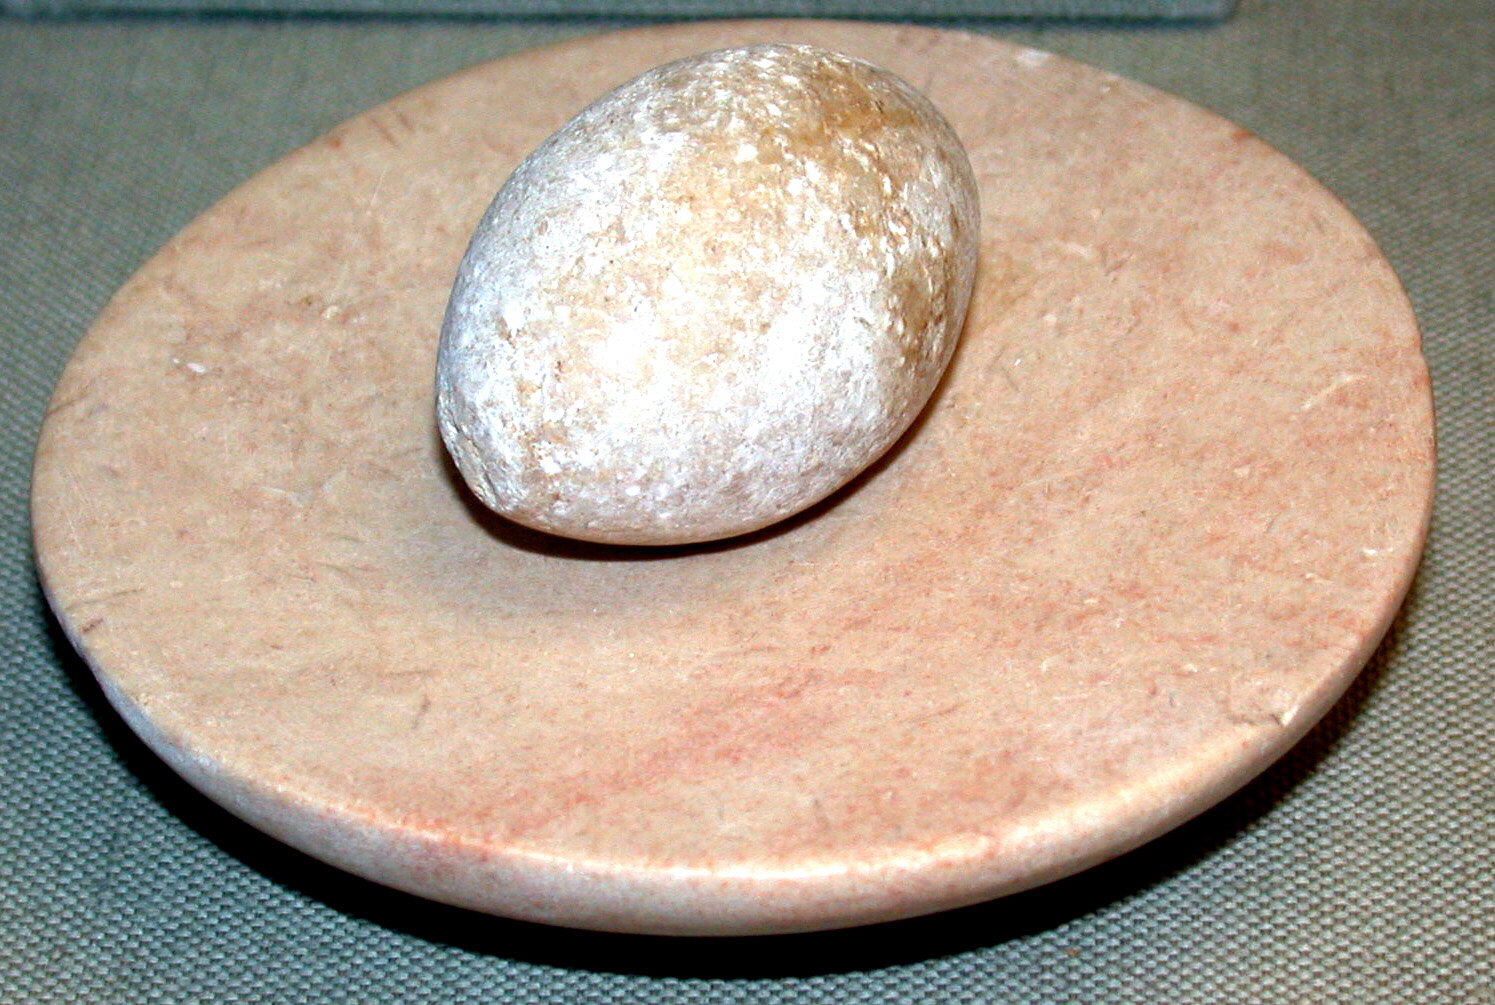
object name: mortar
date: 7333-7001 BCE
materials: limestone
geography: syria